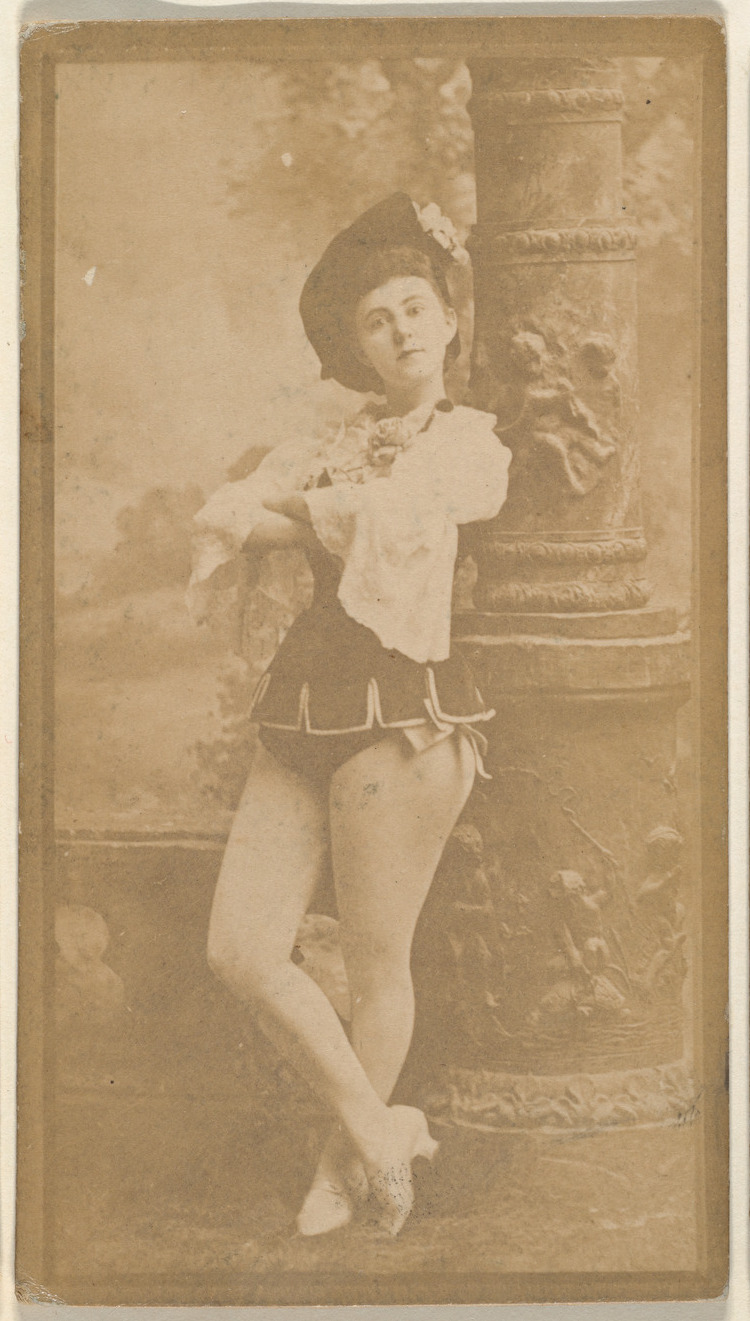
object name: photograph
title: Actress leaning against column, from the Actresses series (N668)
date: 1888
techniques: albumen silver print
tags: portraits,women,actresses